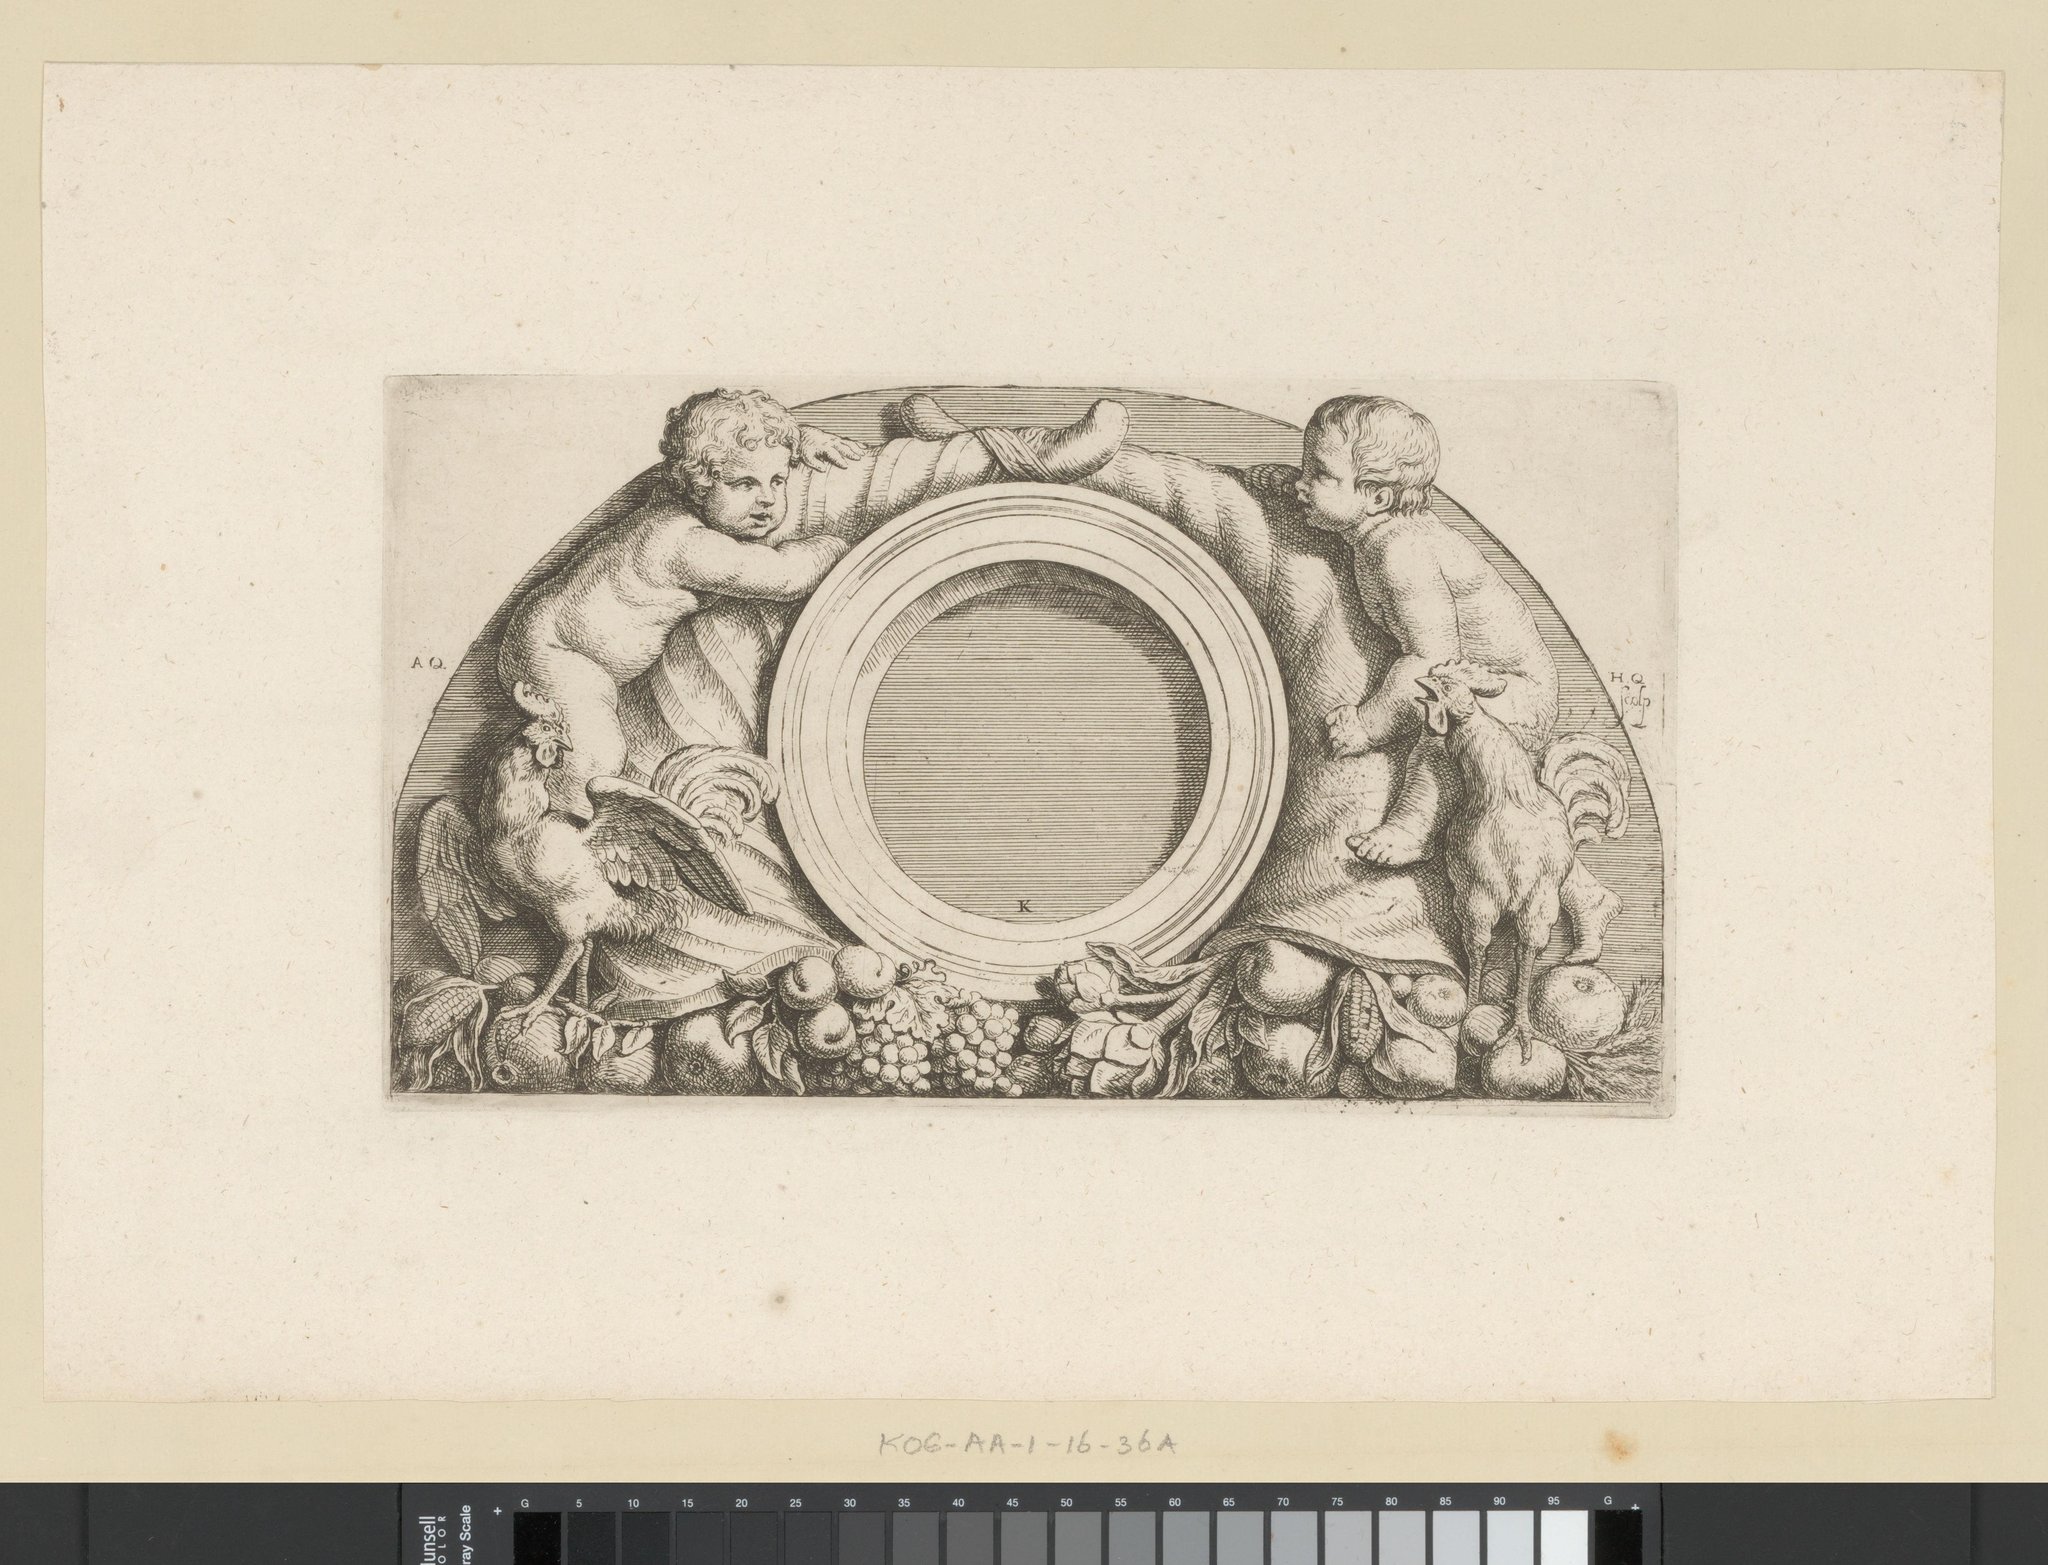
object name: print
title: Lunette met putti, hanen en hoornen des overvloeds in de westelijke galerij van het Stadhuis op de Dam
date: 1655-1665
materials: paper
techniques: engraving, etching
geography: amsterdam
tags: 'cornucopia', horn of plenty, townhall, fowl (cock, hen, chicken, etc.), cupids: 'amores', 'amoretti', 'putti'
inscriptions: collector's mark: ‘16,36’ Lugt 1641b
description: Prent gebruikt in: Prima pars. Praecipuarum effigierum ac ornamentorum, amplissimae Curiae Amstelrodamensis (…) / Het eerste deel. Van de voornaemste Statuen ende Ciraten, vant konstijck Stadhuys van Amstelredam, tmeeste in marmer gemaeckt, door Artus Quellinus, Beelthouwer der voorseyde Stadt / La Premier Partie. De plusieurs Figures et ornements, de la Maison de Ville d'Amsterdam (…). Amsterdam: Artus Quellinus (I), 1655. Zie RP-P-AO-22-1-1 voor bijhorende titelpagina. Zie RP-P-AO-22-1-2 voor bijhorend register. Zie RP-P-AO-22-1A, RP-P-AO-22-1B, RP-P-AO-22-1C, RP-P-AO-22-1D-1, RP-P-AO-22-1D-2, RP-P-AO-22-1E, RP-P-AO-22-1F, RP-P-AO-22-1G, RP-P-AO-22-1H, RP-P-AO-22-1I, RP-P-AO-22-1K-1, RP-P-AO-22-1K-3, RP-P-AO-22-1K-4, RP-P-AO-22-1K-5, RP-P-AO-22-1L-1, RP-P-AO-22-1L-2, RP-P-AO-22-1M-1, RP-P-AO-22-1M-2, RP-P-AO-22-1N-1, RP-P-AO-22-1N-2, RP-P-AO-22-1N-3, RP-P-AO-22-1N-4, RP-P-AO-22-1N-5, RP-P-AO-22-1O-1, RP-P-AO-22-1O-2, RP-P-AO-22-1O-3, RP-P-AO-22-1O-4, RP-P-AO-22-1P-1, RP-P-AO-22-1P-2, RP-P-AO-22-1P-3, RP-P-AO-22-1P-4, RP-P-AO-22-1Q-1, RP-P-AO-22-1Q-2, RP-P-AO-22-1Q-3, RP-P-AO-22-1Q-4, RP-P-AO-22-1R-1, RP-P-AO-22-1R-2, RP-P-AO-22-1R-3, RP-P-AO-22-1R-4, RP-P-AO-22-1R-5, RP-P-AO-22-1S-1, RP-P-AO-22-1S-2, RP-P-AO-22-1S-3, RP-P-AO-22-1S-4, RP-P-AO-22-1S-5, RP-P-AO-22-1T-1 en RP-P-AO-22-1T-2 voor andere prenten uit deze publicatie. Zelfde staat van prent ook gebruikt in: Prima pars. Praecipuarum effigierum ac ornamentorum, amplissimae Curiae Amstelrodamensis (…) / Het eerste deel. Van de voornaemste Statuen ende Ciraten, vant konstijck Stadhuys van Amstelredam, tmeeste in marmer gemaeckt, door Artus Quellinus, Beelthouwer der voorseyde Stadt / La Premier Partie. De plusieurs Figures et ornements, de la Maison de Ville d'Amsterdam (…). Amsterdam: Frederik de Wit, 1665. Latere staat van prent ook gebruikt in: Architecture peinture et sculpture de la Maison de Ville d'Amsterdam, representee en CIX. figures en taille-douce (…). Amsterdam: David Mortier, 1719. En in: Architecture peinture et sculpture de la Maison de Ville d'Amsterdam, representee en CIX. figures en taille-douce (…). Amsterdam: Gerard Valck, 1719. En in: Bouw schilder en beeldhouwkonst, van het Stadhuis te Amsteldam, vertoont in CIX figuuren (…). Amsterdam: Covens & Mortier & Covens Jr., s.a. (1774-1783).